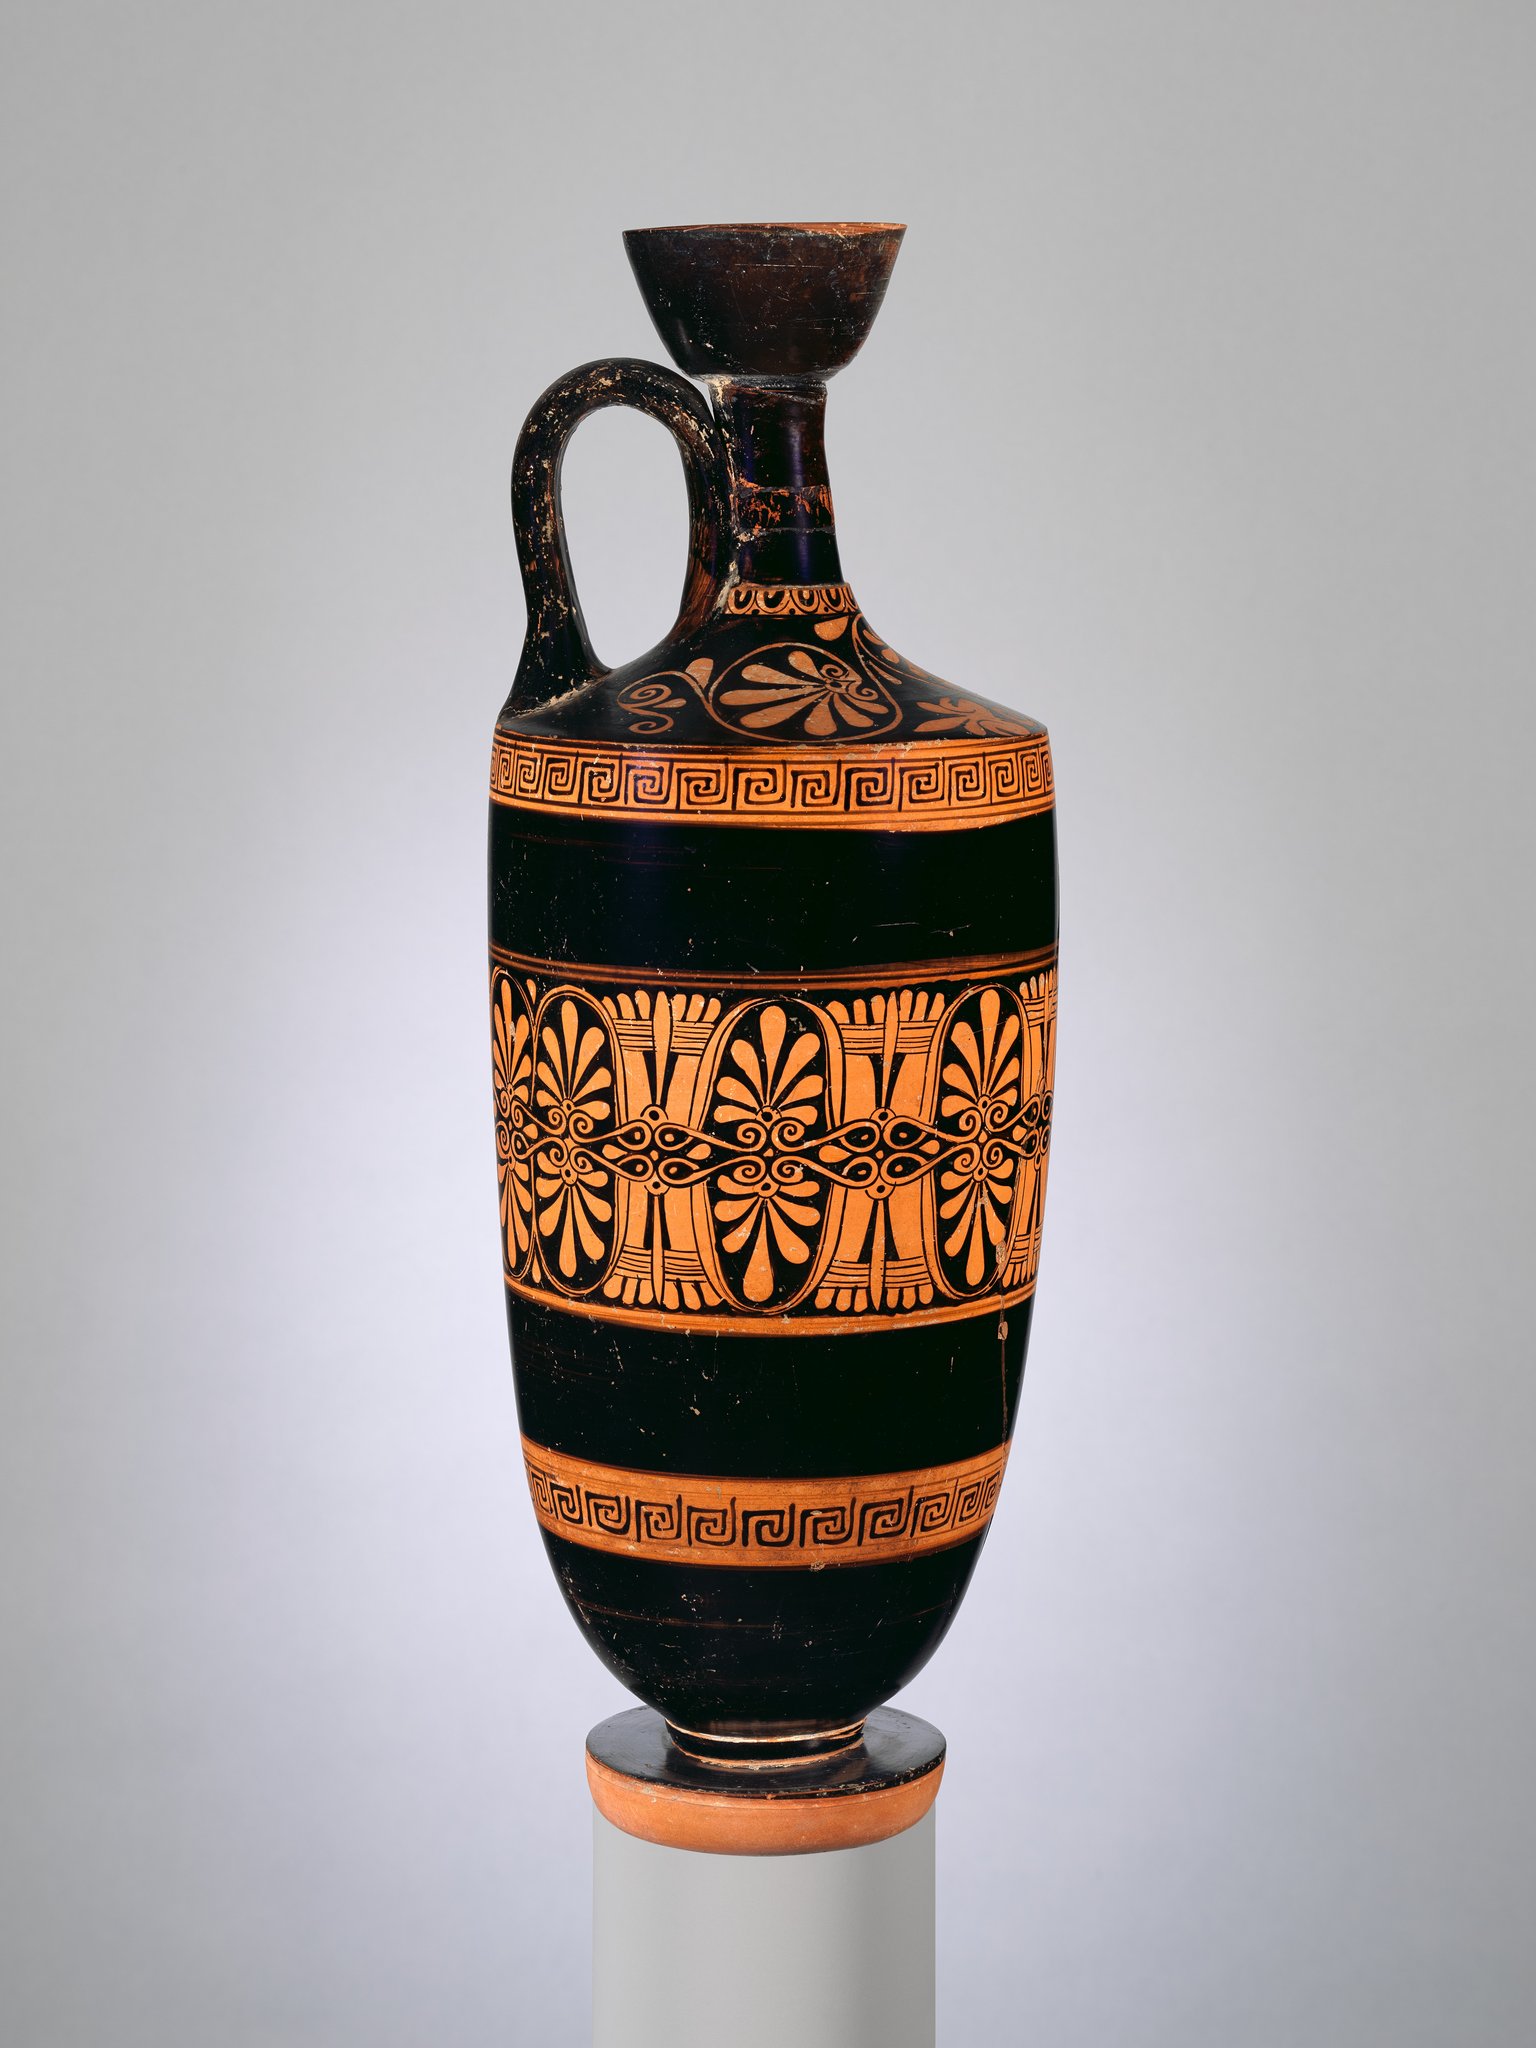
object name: lekythos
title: Terracotta lekythos (oil flask)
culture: greek, attic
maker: nikon painter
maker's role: artist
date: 470-460 BCE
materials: terracotta